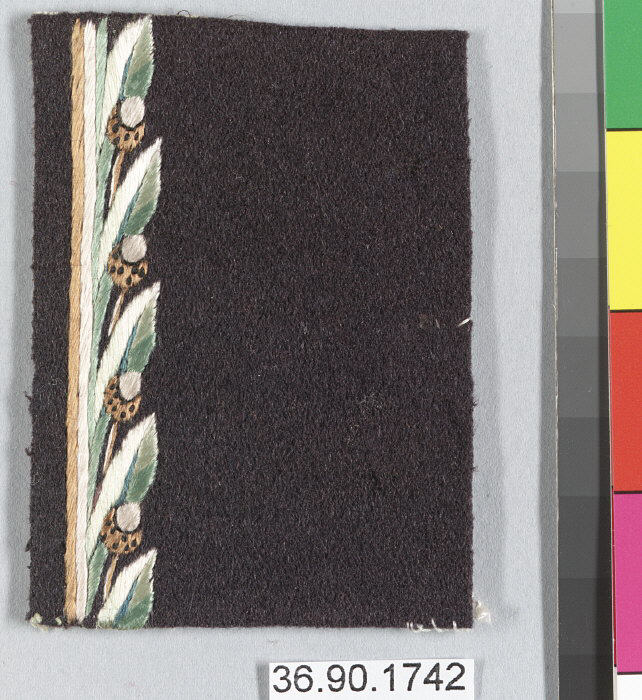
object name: sample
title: Embroidery sample for a man’s suit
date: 1785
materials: silk, wool